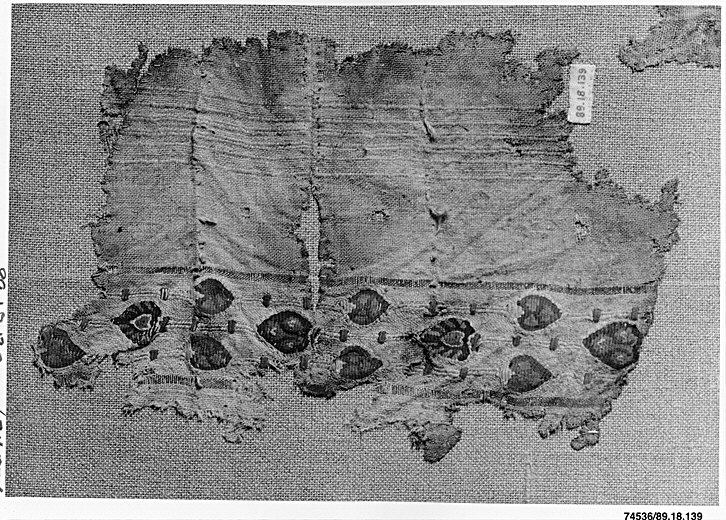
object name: textile fragment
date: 401-500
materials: linen, wool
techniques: weave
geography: egypt